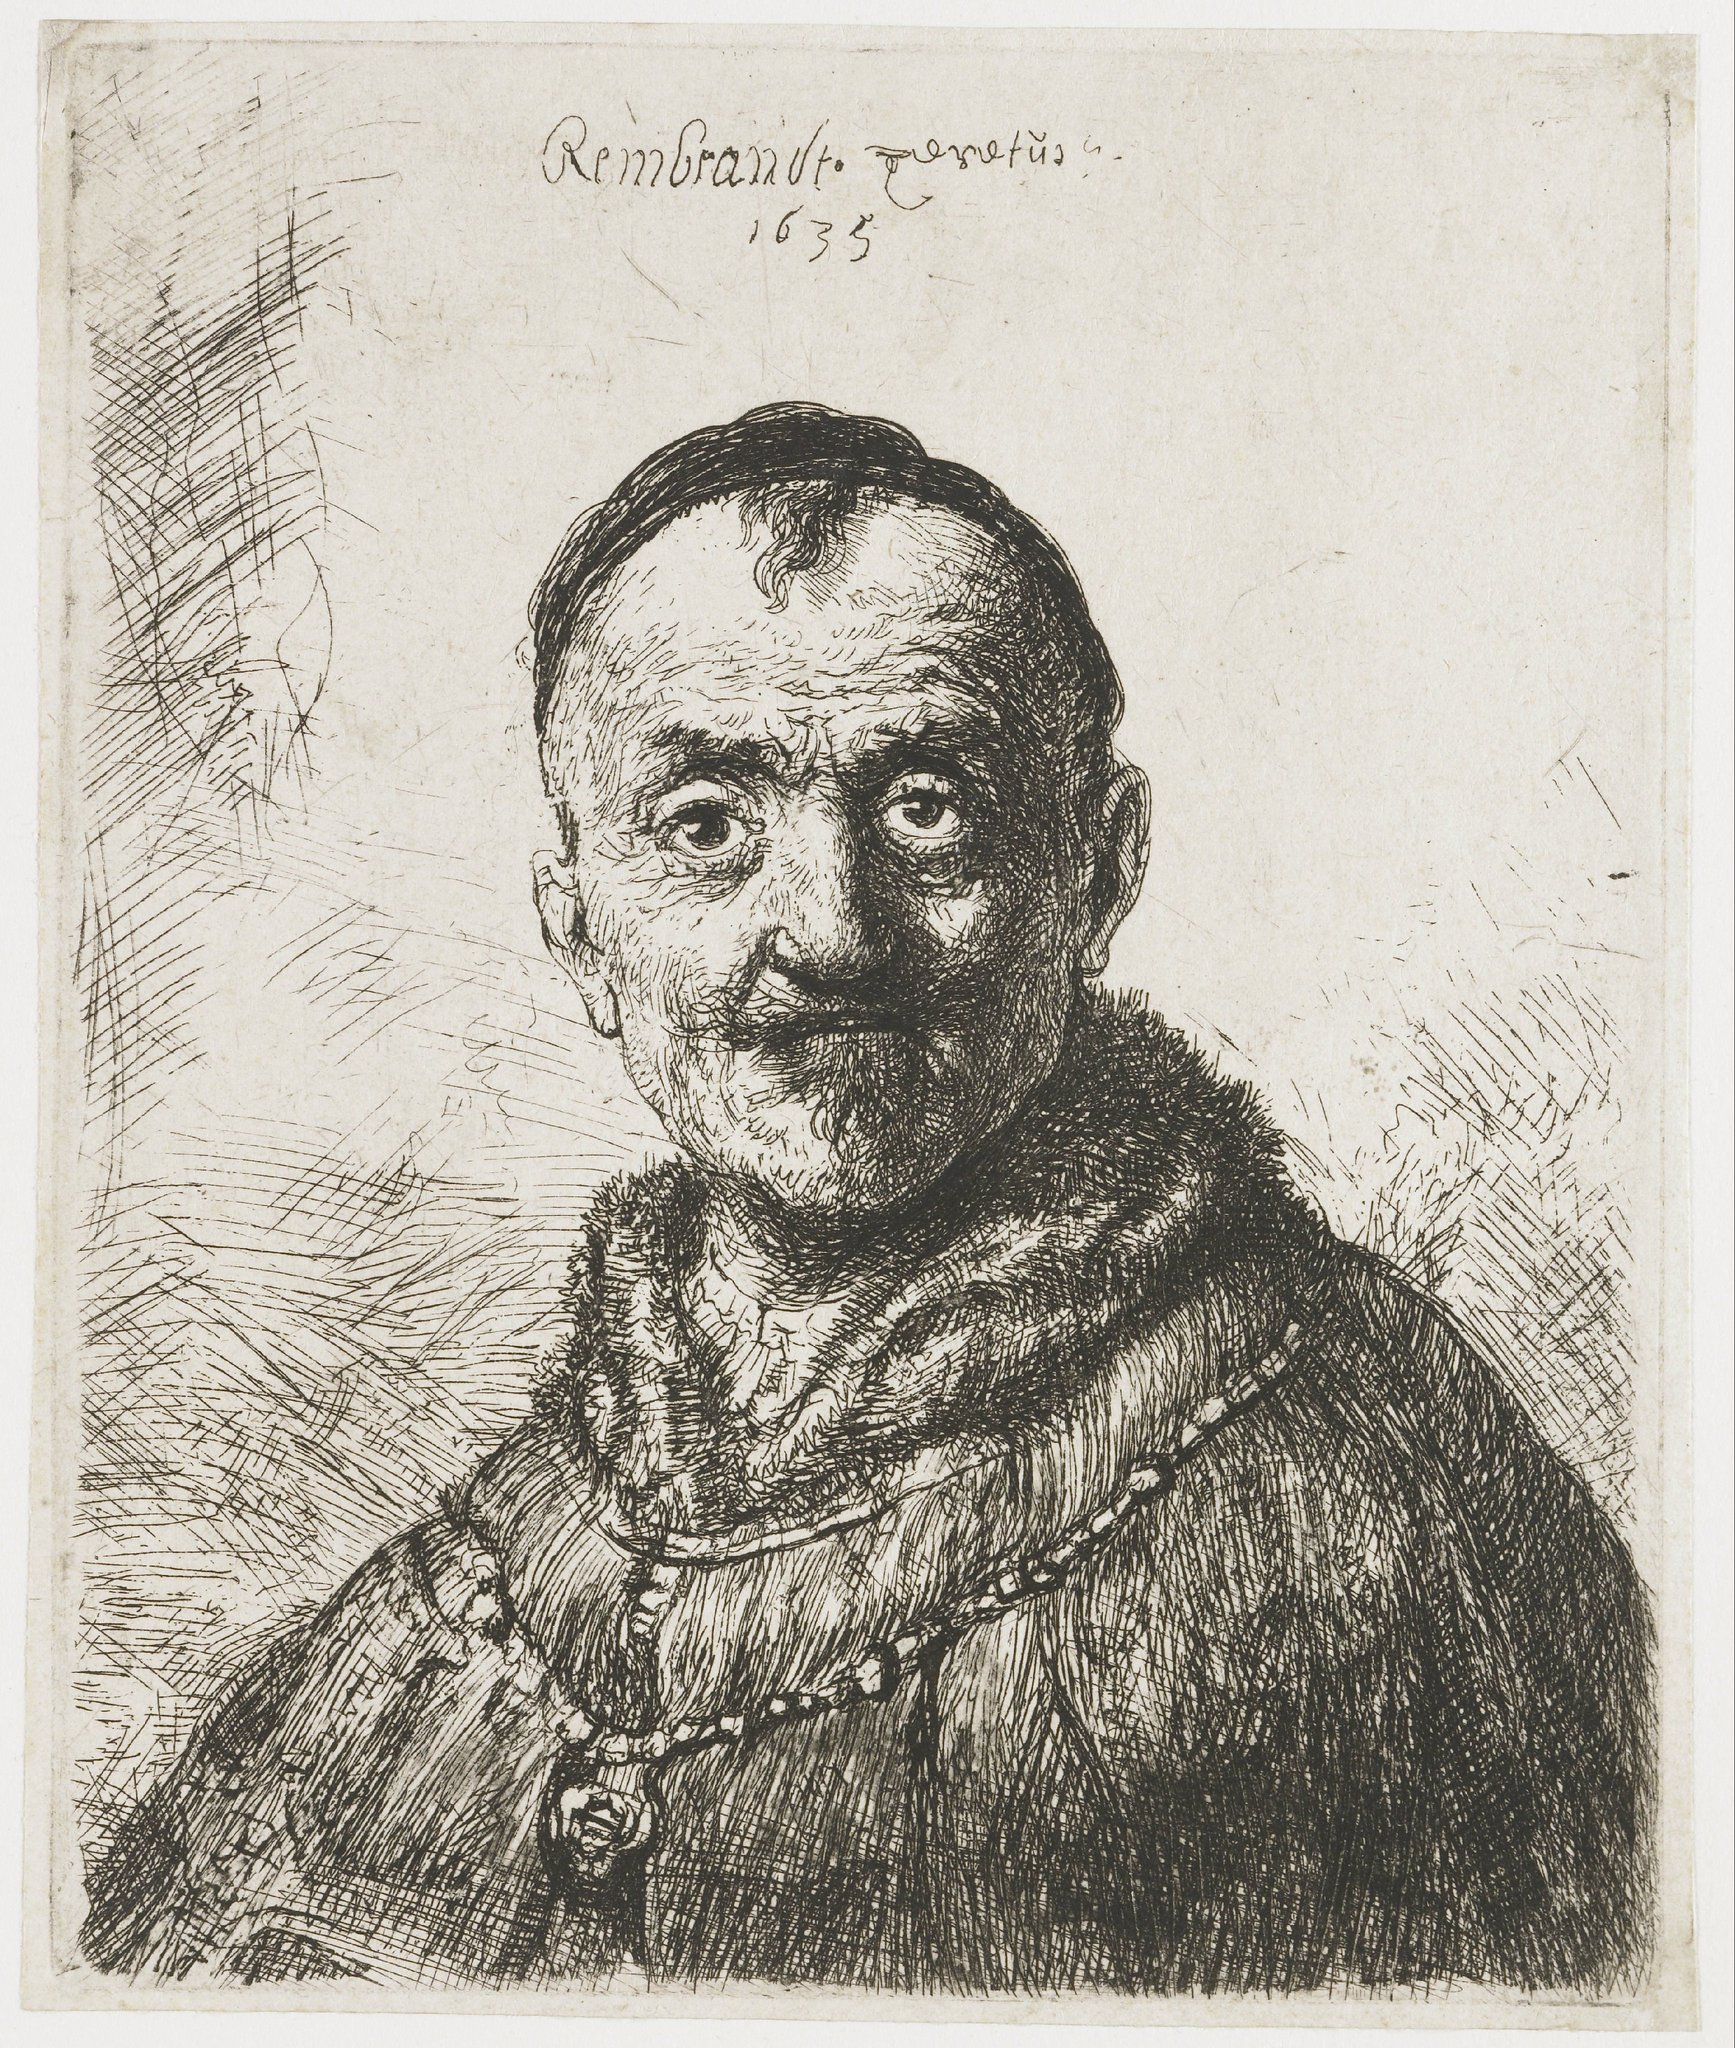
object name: print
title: The first Oriental head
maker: rembrandt van rijn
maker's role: draughtsman, painter, print maker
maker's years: 1606-1669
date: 1635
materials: paper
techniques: drypoint, etching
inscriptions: signature and date: ‘Rembrandt geretuc 1635’, collector's mark: Lugt 240